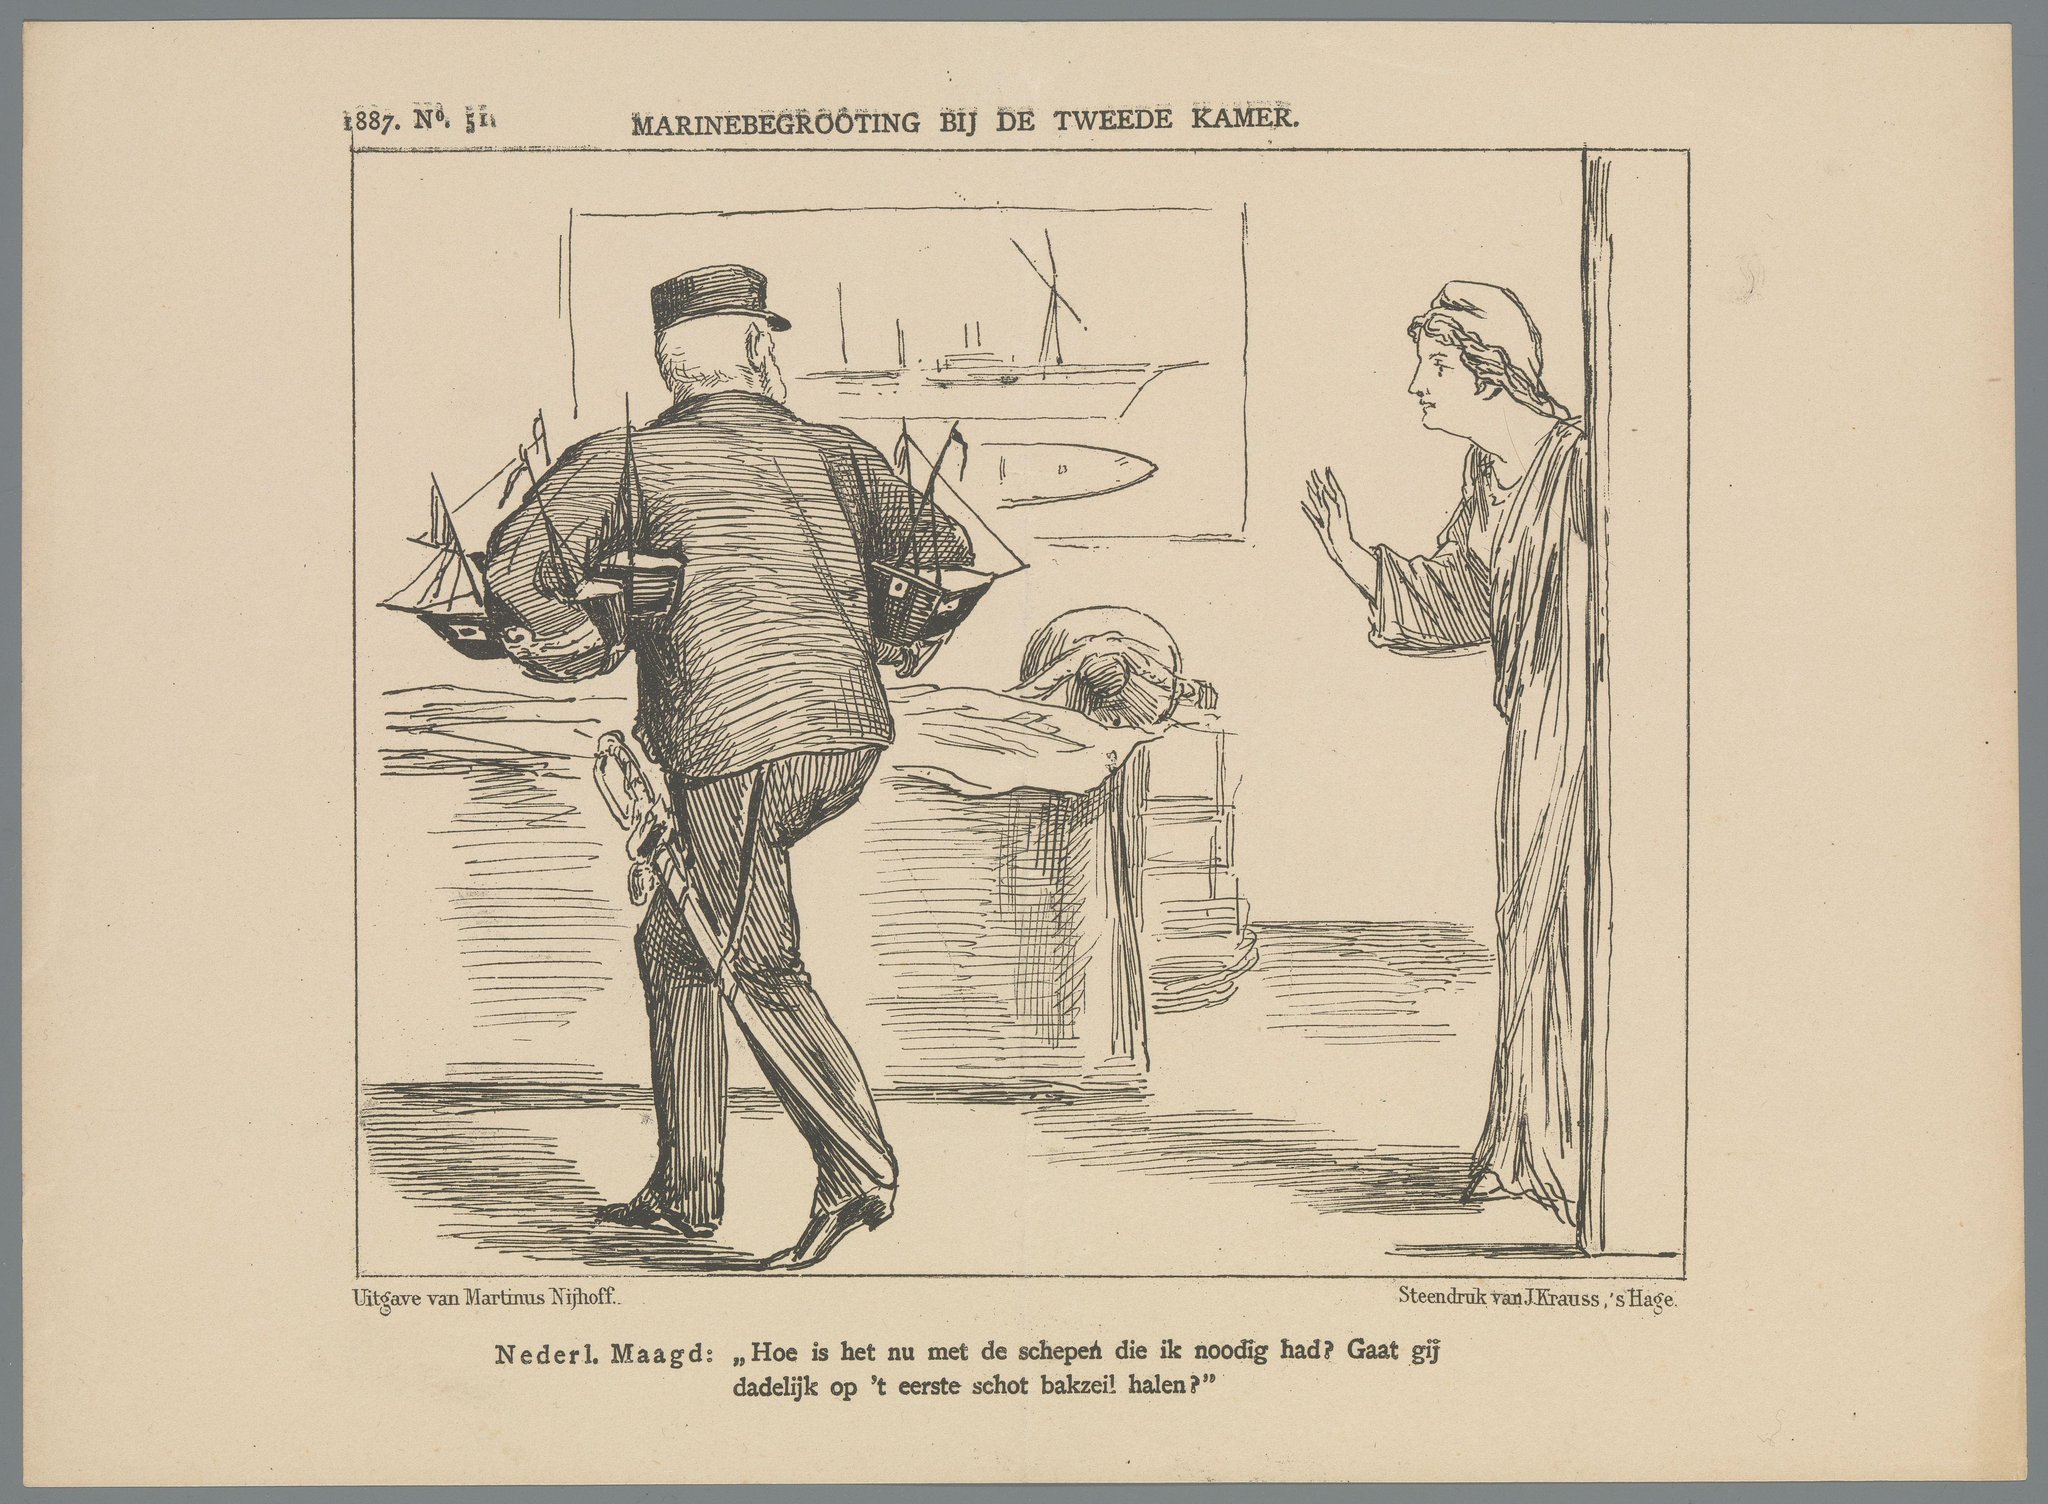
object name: print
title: Spotprent over de marinebegroting, 1887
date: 1887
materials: paper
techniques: lithograph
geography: the hague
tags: personifications of countries, nations, states, districts, etc.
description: Spotprent over de behandeling van de marinebegroting in de Tweede Kamer. Plaat verschenen bij het weekblad De Nederlandsche Spectator, nr. 51, 1887.